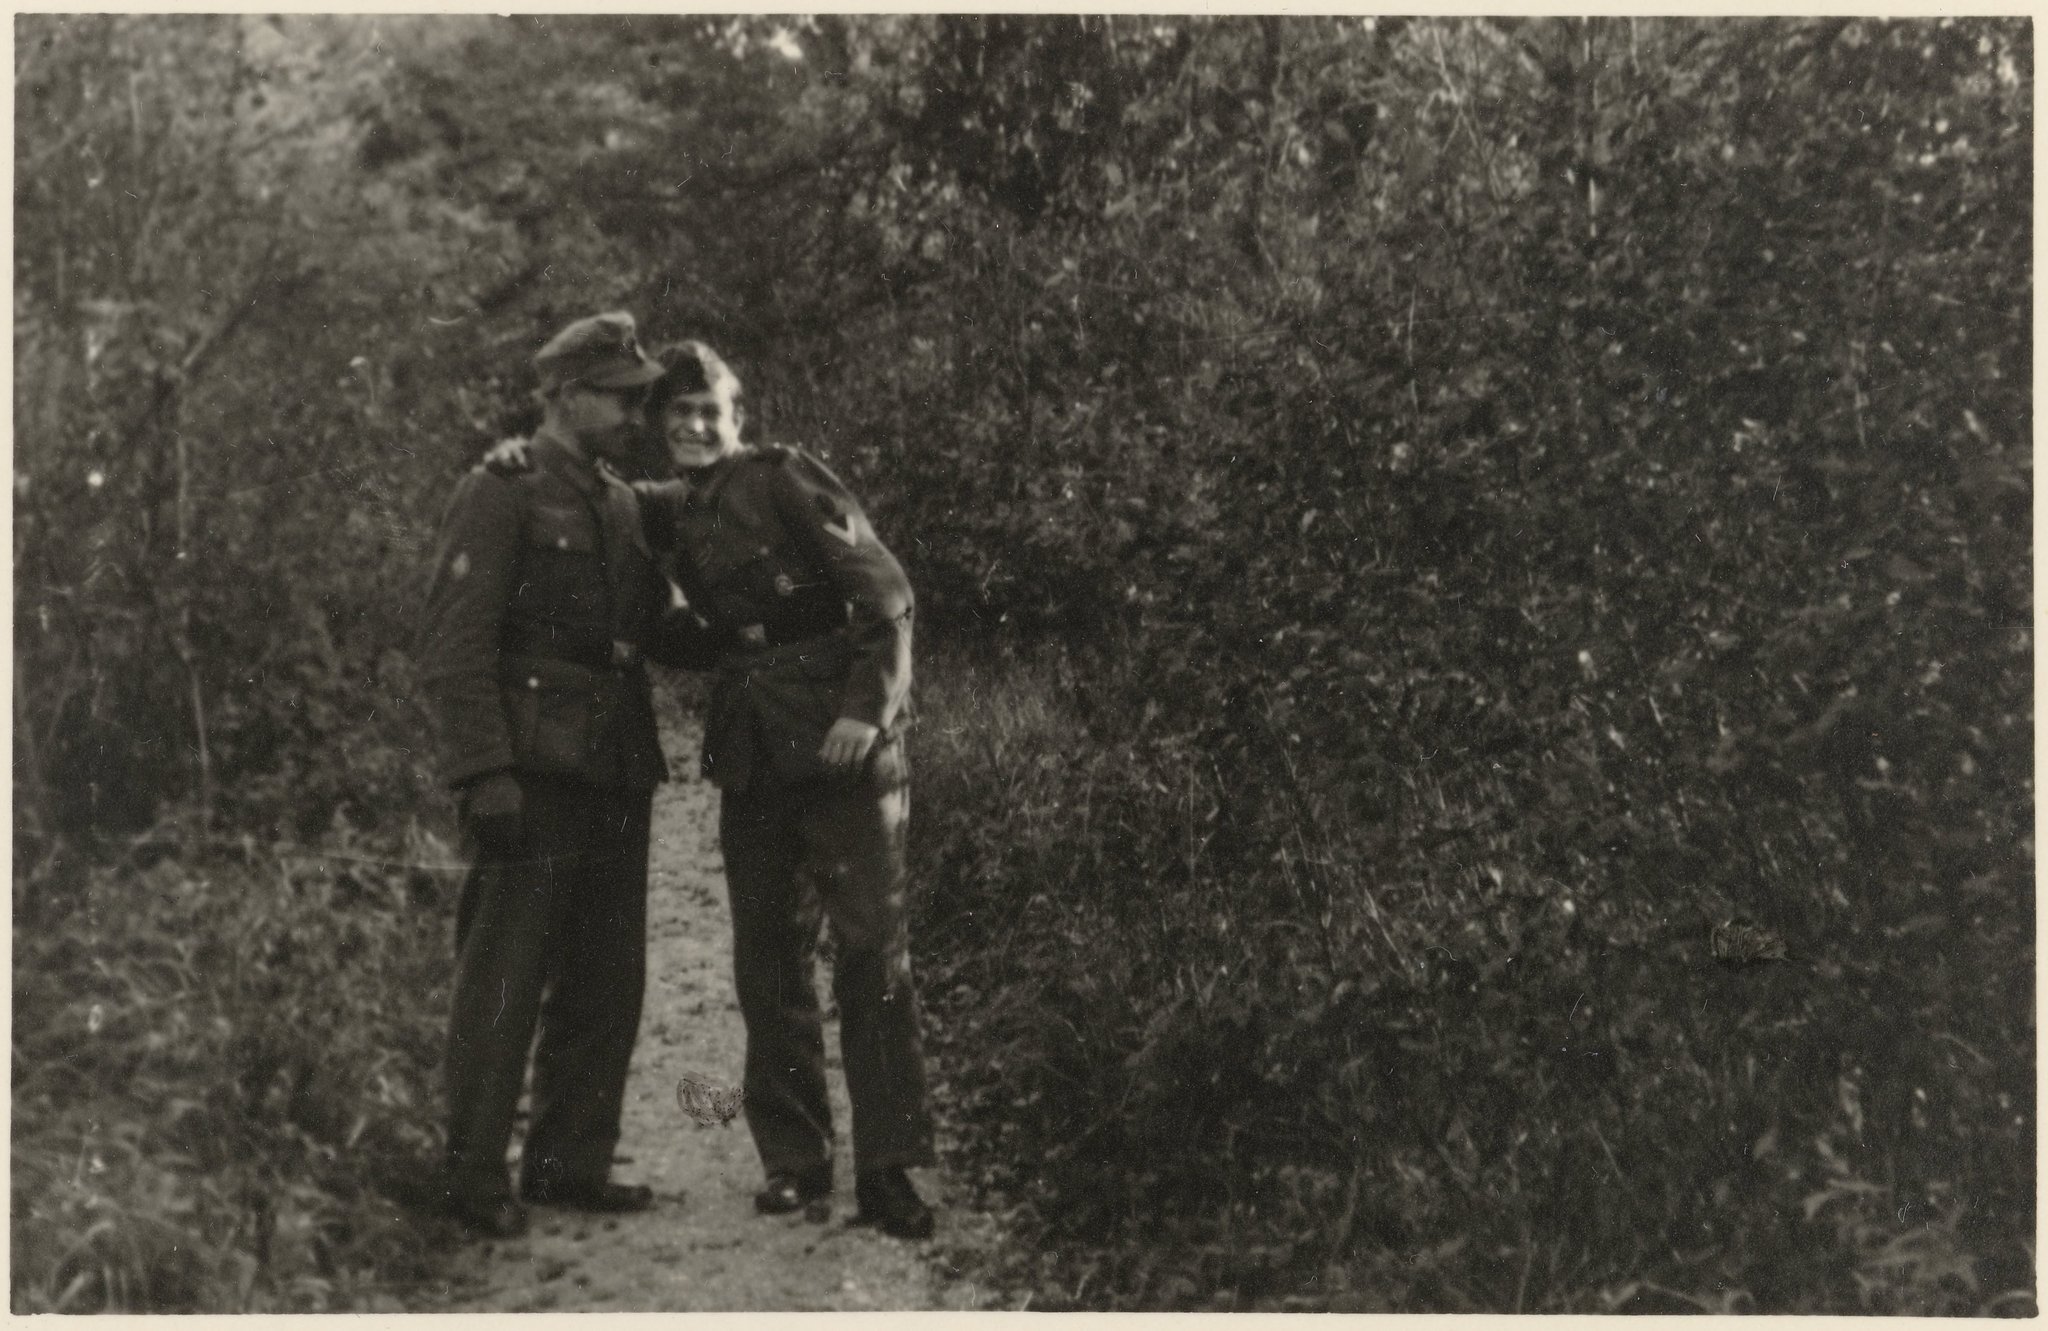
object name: photograph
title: Twee bevriende Duitse militairen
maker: Anonymous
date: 1940-1945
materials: photographic support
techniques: gelatin silver print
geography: netherlands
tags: germany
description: Twee bevriende Duitse militairen in een bos met de armen om elkaar. Foto behorend bij album 'Kriegserinnerungen'.